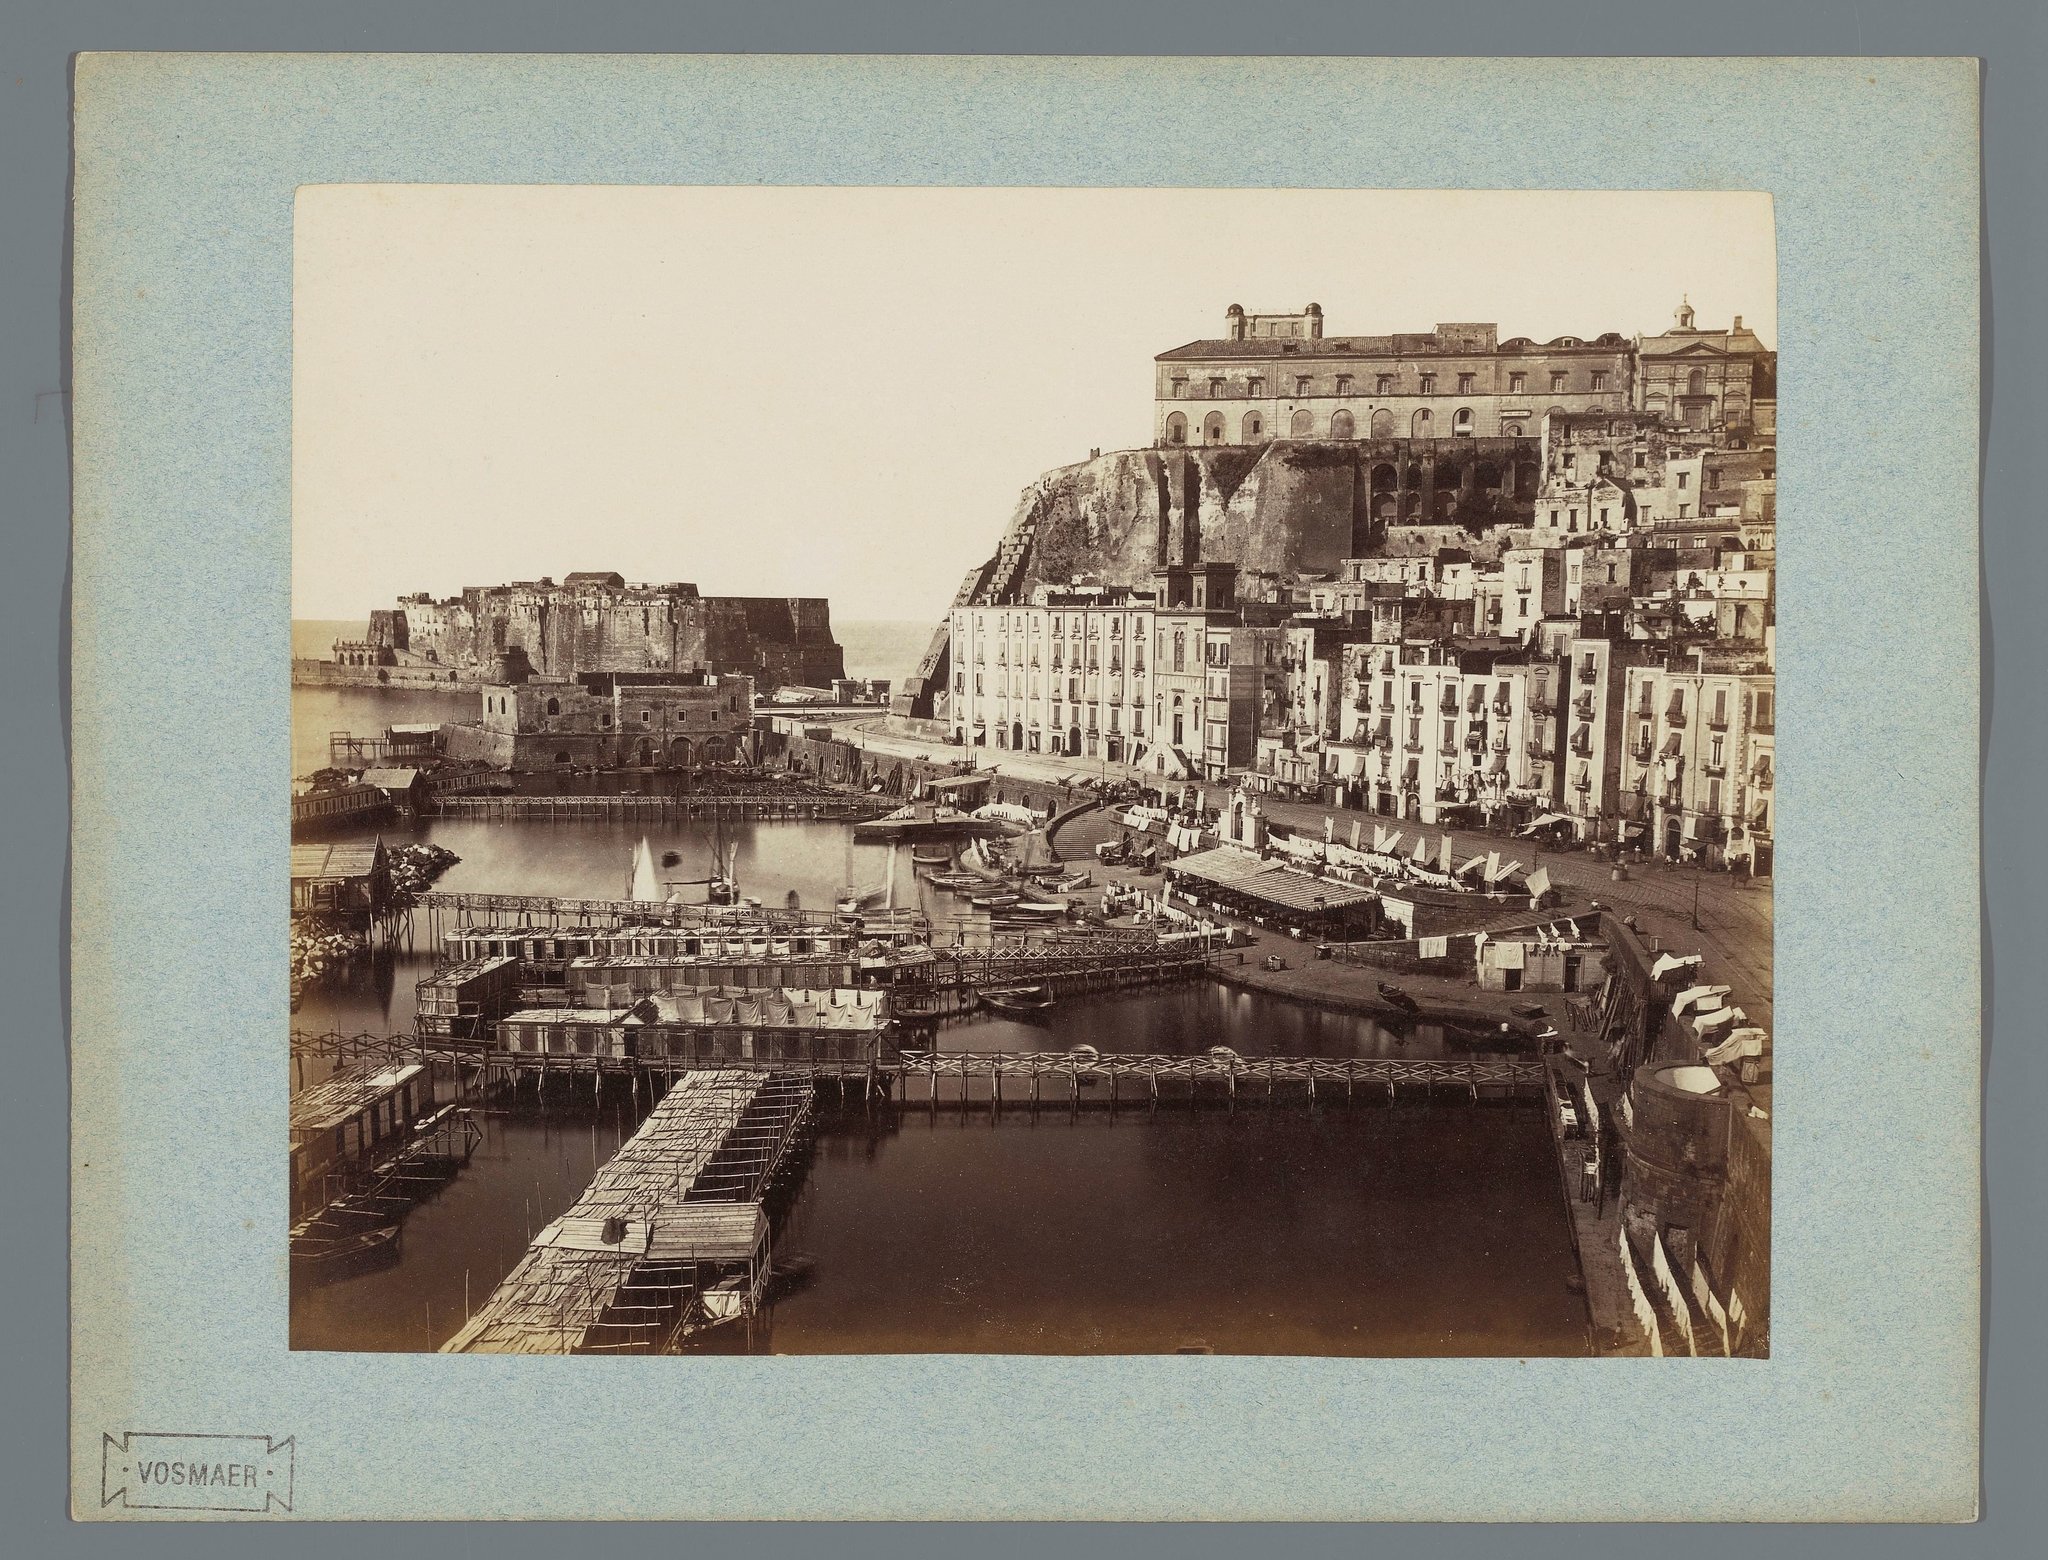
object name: ansichtkaart, prentbriefkaart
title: Portret van Wies Dusee als heks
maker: Anonymous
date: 1919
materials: photographic support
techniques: gelatin silver print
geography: netherlands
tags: tilburg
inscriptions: inscription: ‘Wies Dusee, Tilburg 1919’